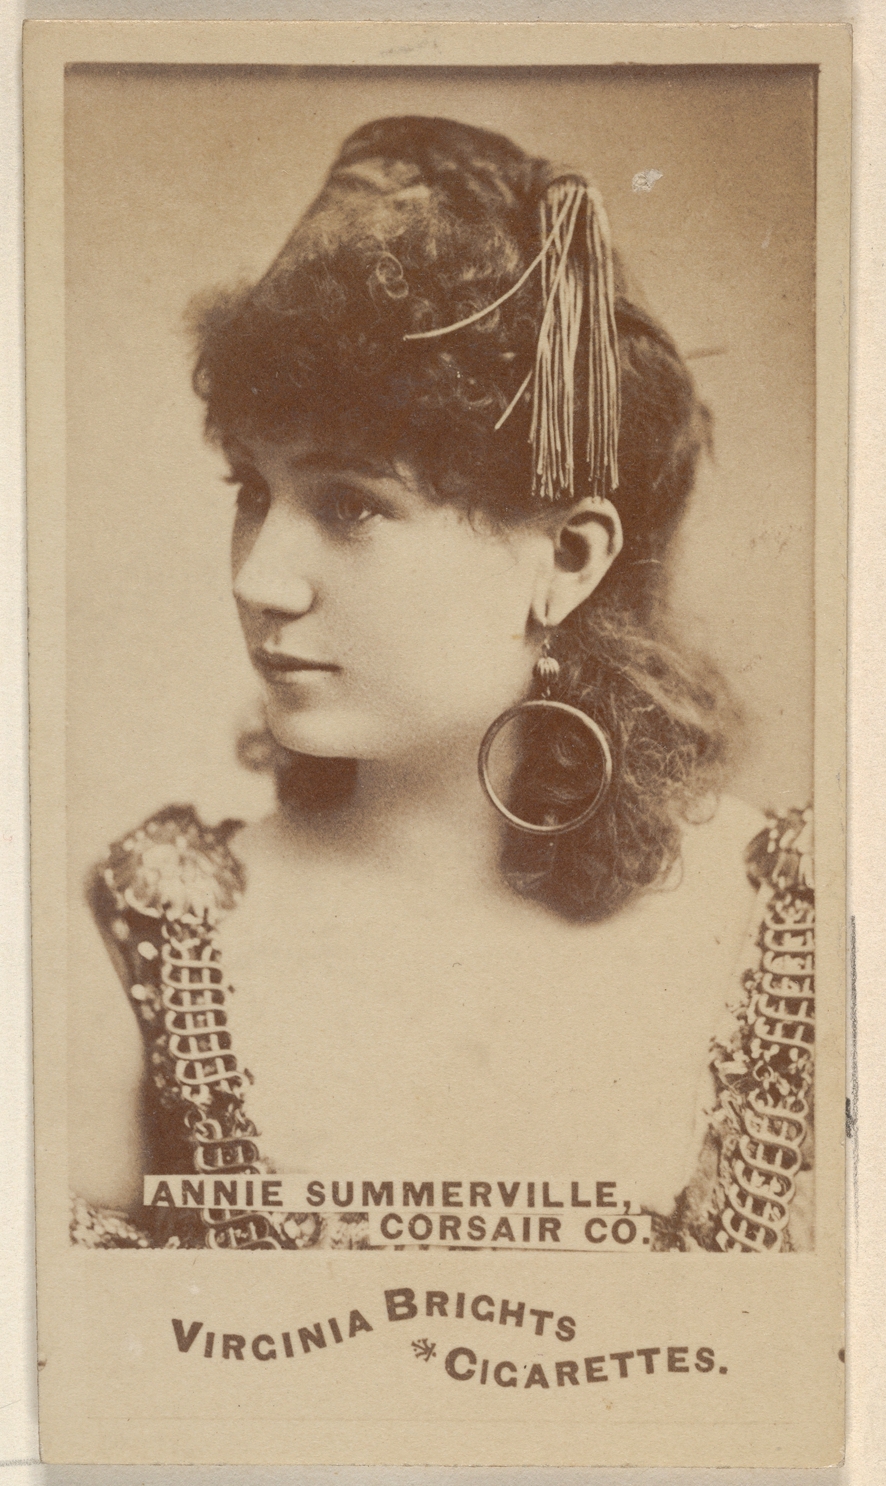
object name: photograph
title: Annie Summerville, Corsair Co., from the Actors and Actresses series (N45, Type 6) for Virginia Brights Cigarettes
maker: allen & ginter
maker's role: publisher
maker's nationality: american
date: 1888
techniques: albumen silver print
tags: portraits,women,actresses